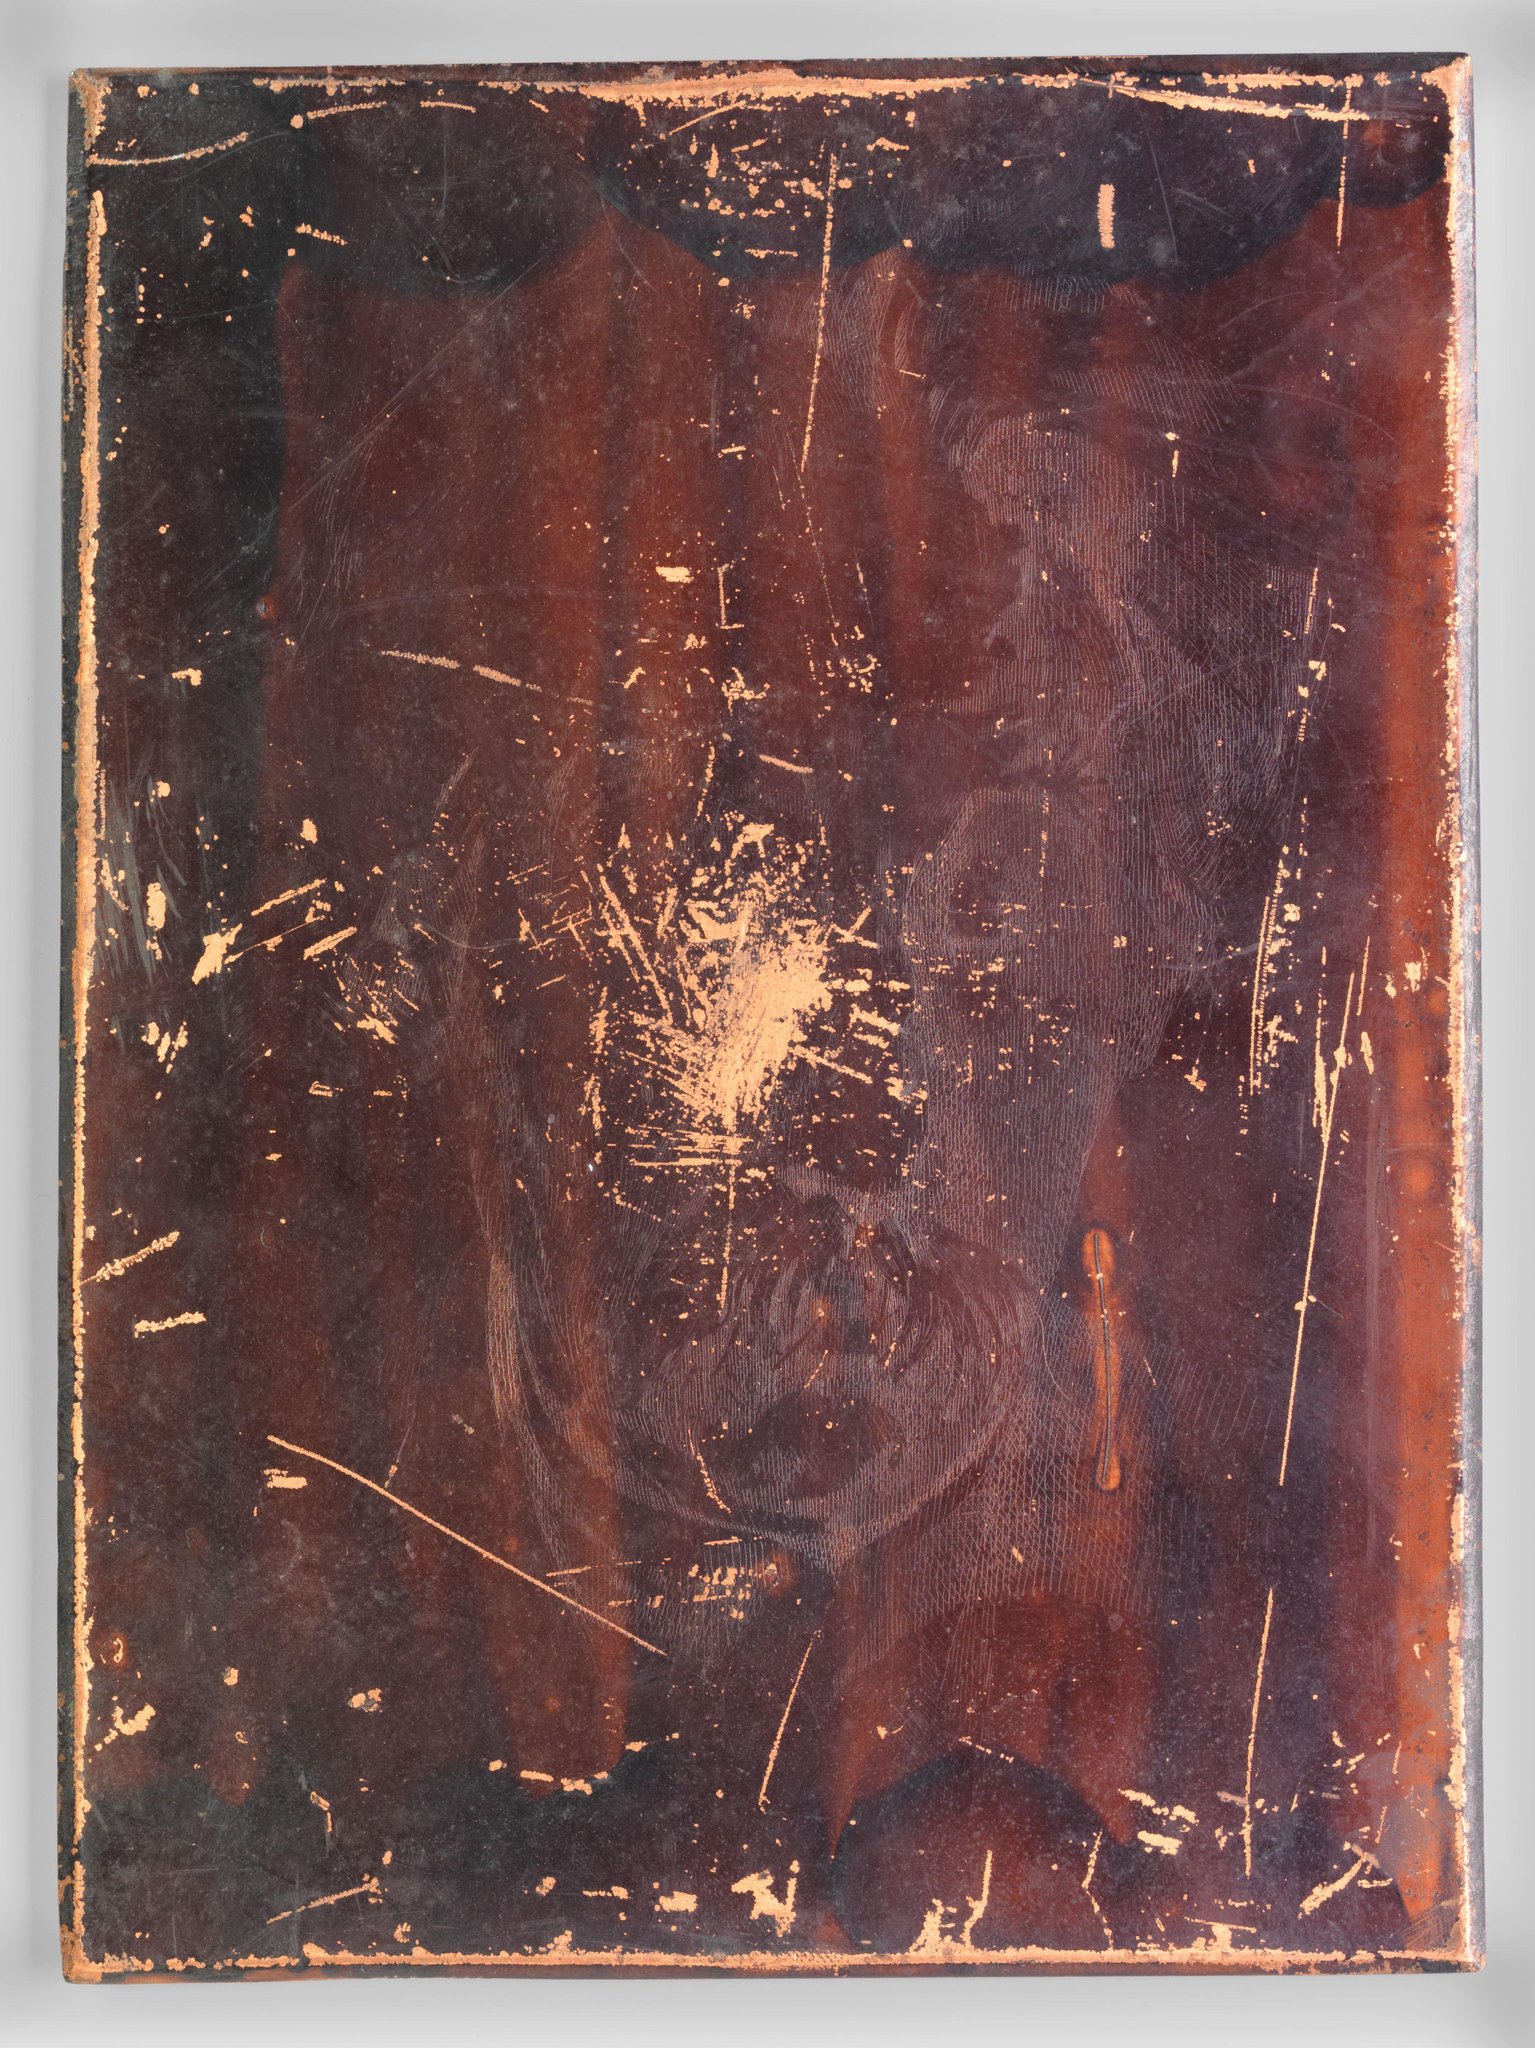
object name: copper plate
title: Portret van dr. Jacob Christiaan Muller en face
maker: willem witsen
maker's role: draughtsman, painter, print maker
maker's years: 1860-1923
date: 1884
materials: copper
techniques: etching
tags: dokter, jacob christiaan muller